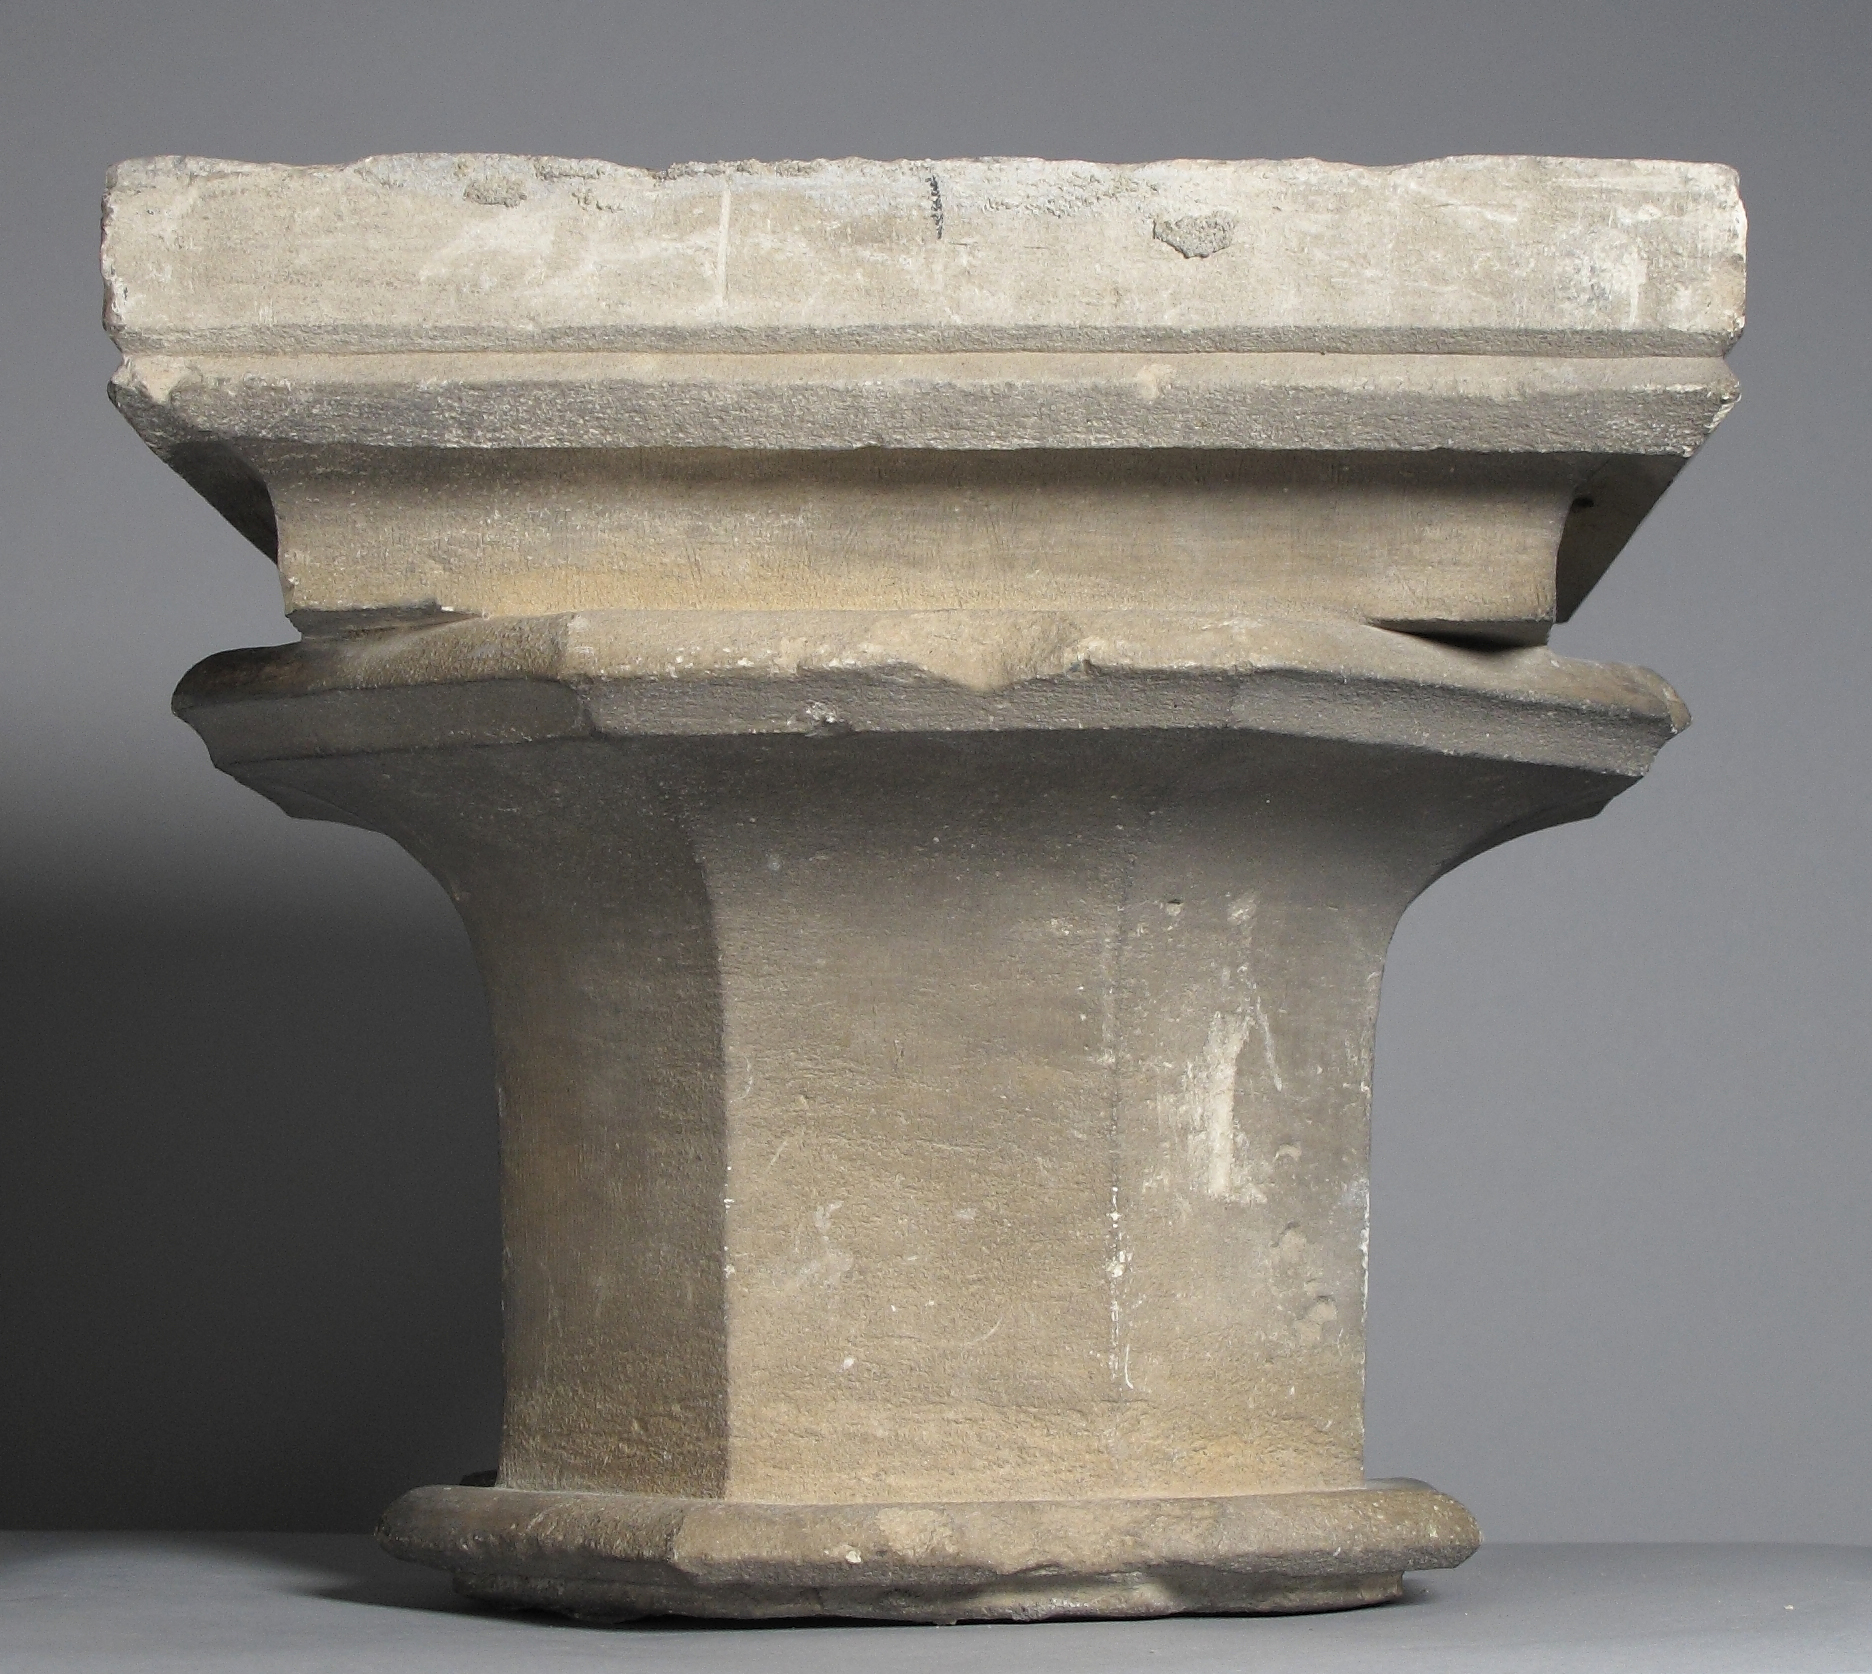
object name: base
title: Column Base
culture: french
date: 1167-1200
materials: stone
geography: france